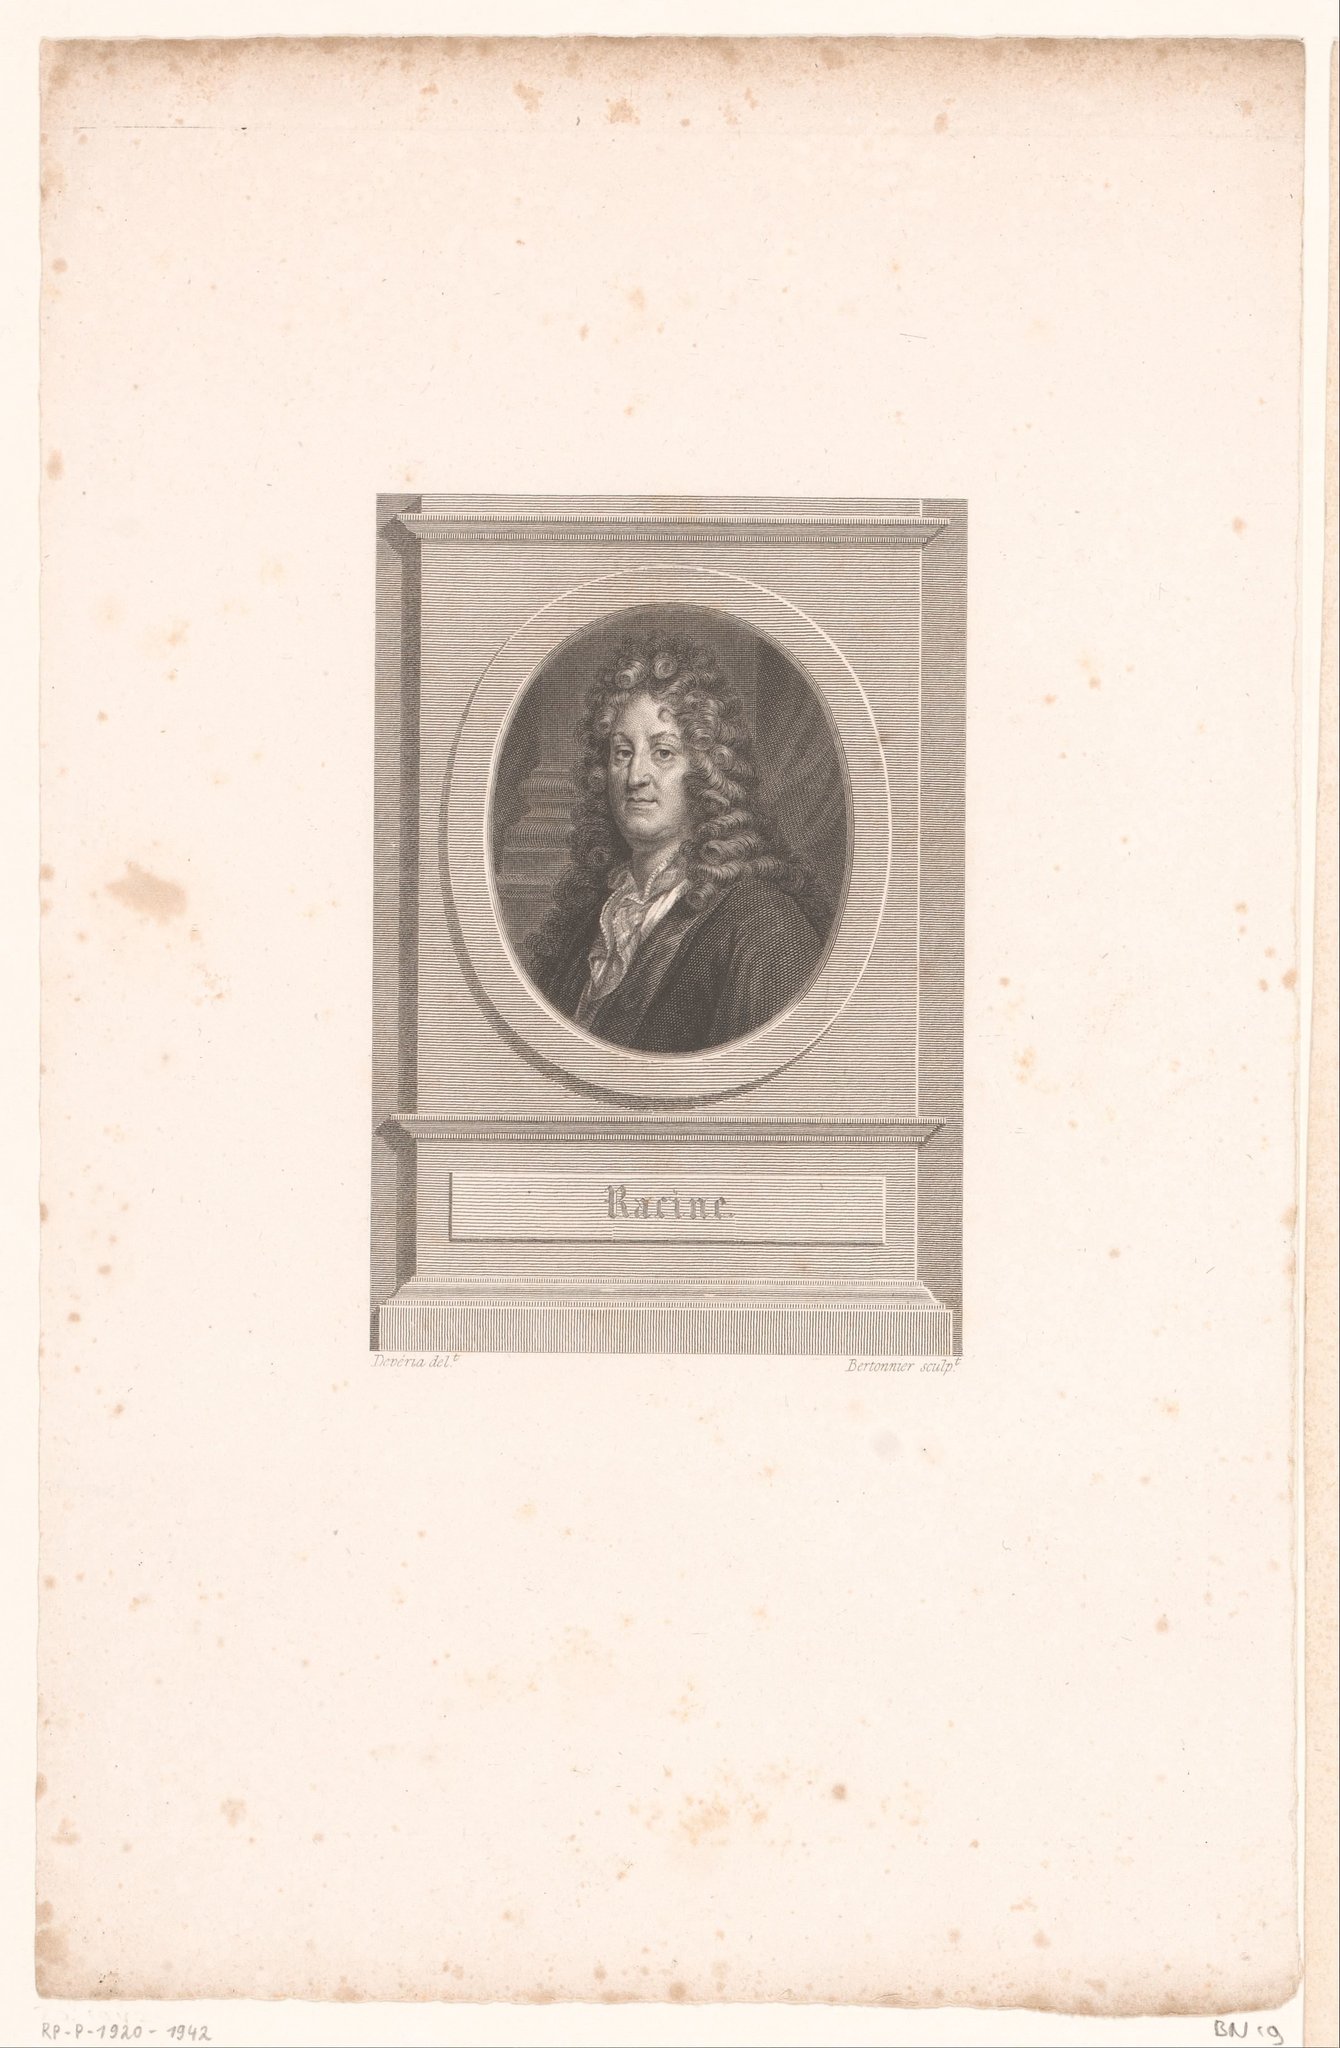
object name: book illustration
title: Portret van Jean Racine in een monumentale lijst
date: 1823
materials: paper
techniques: engraving, etching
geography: france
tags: france, paris, jean racine, ornament ~ medallion, historical persons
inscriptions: collector's mark: Lugt 2228